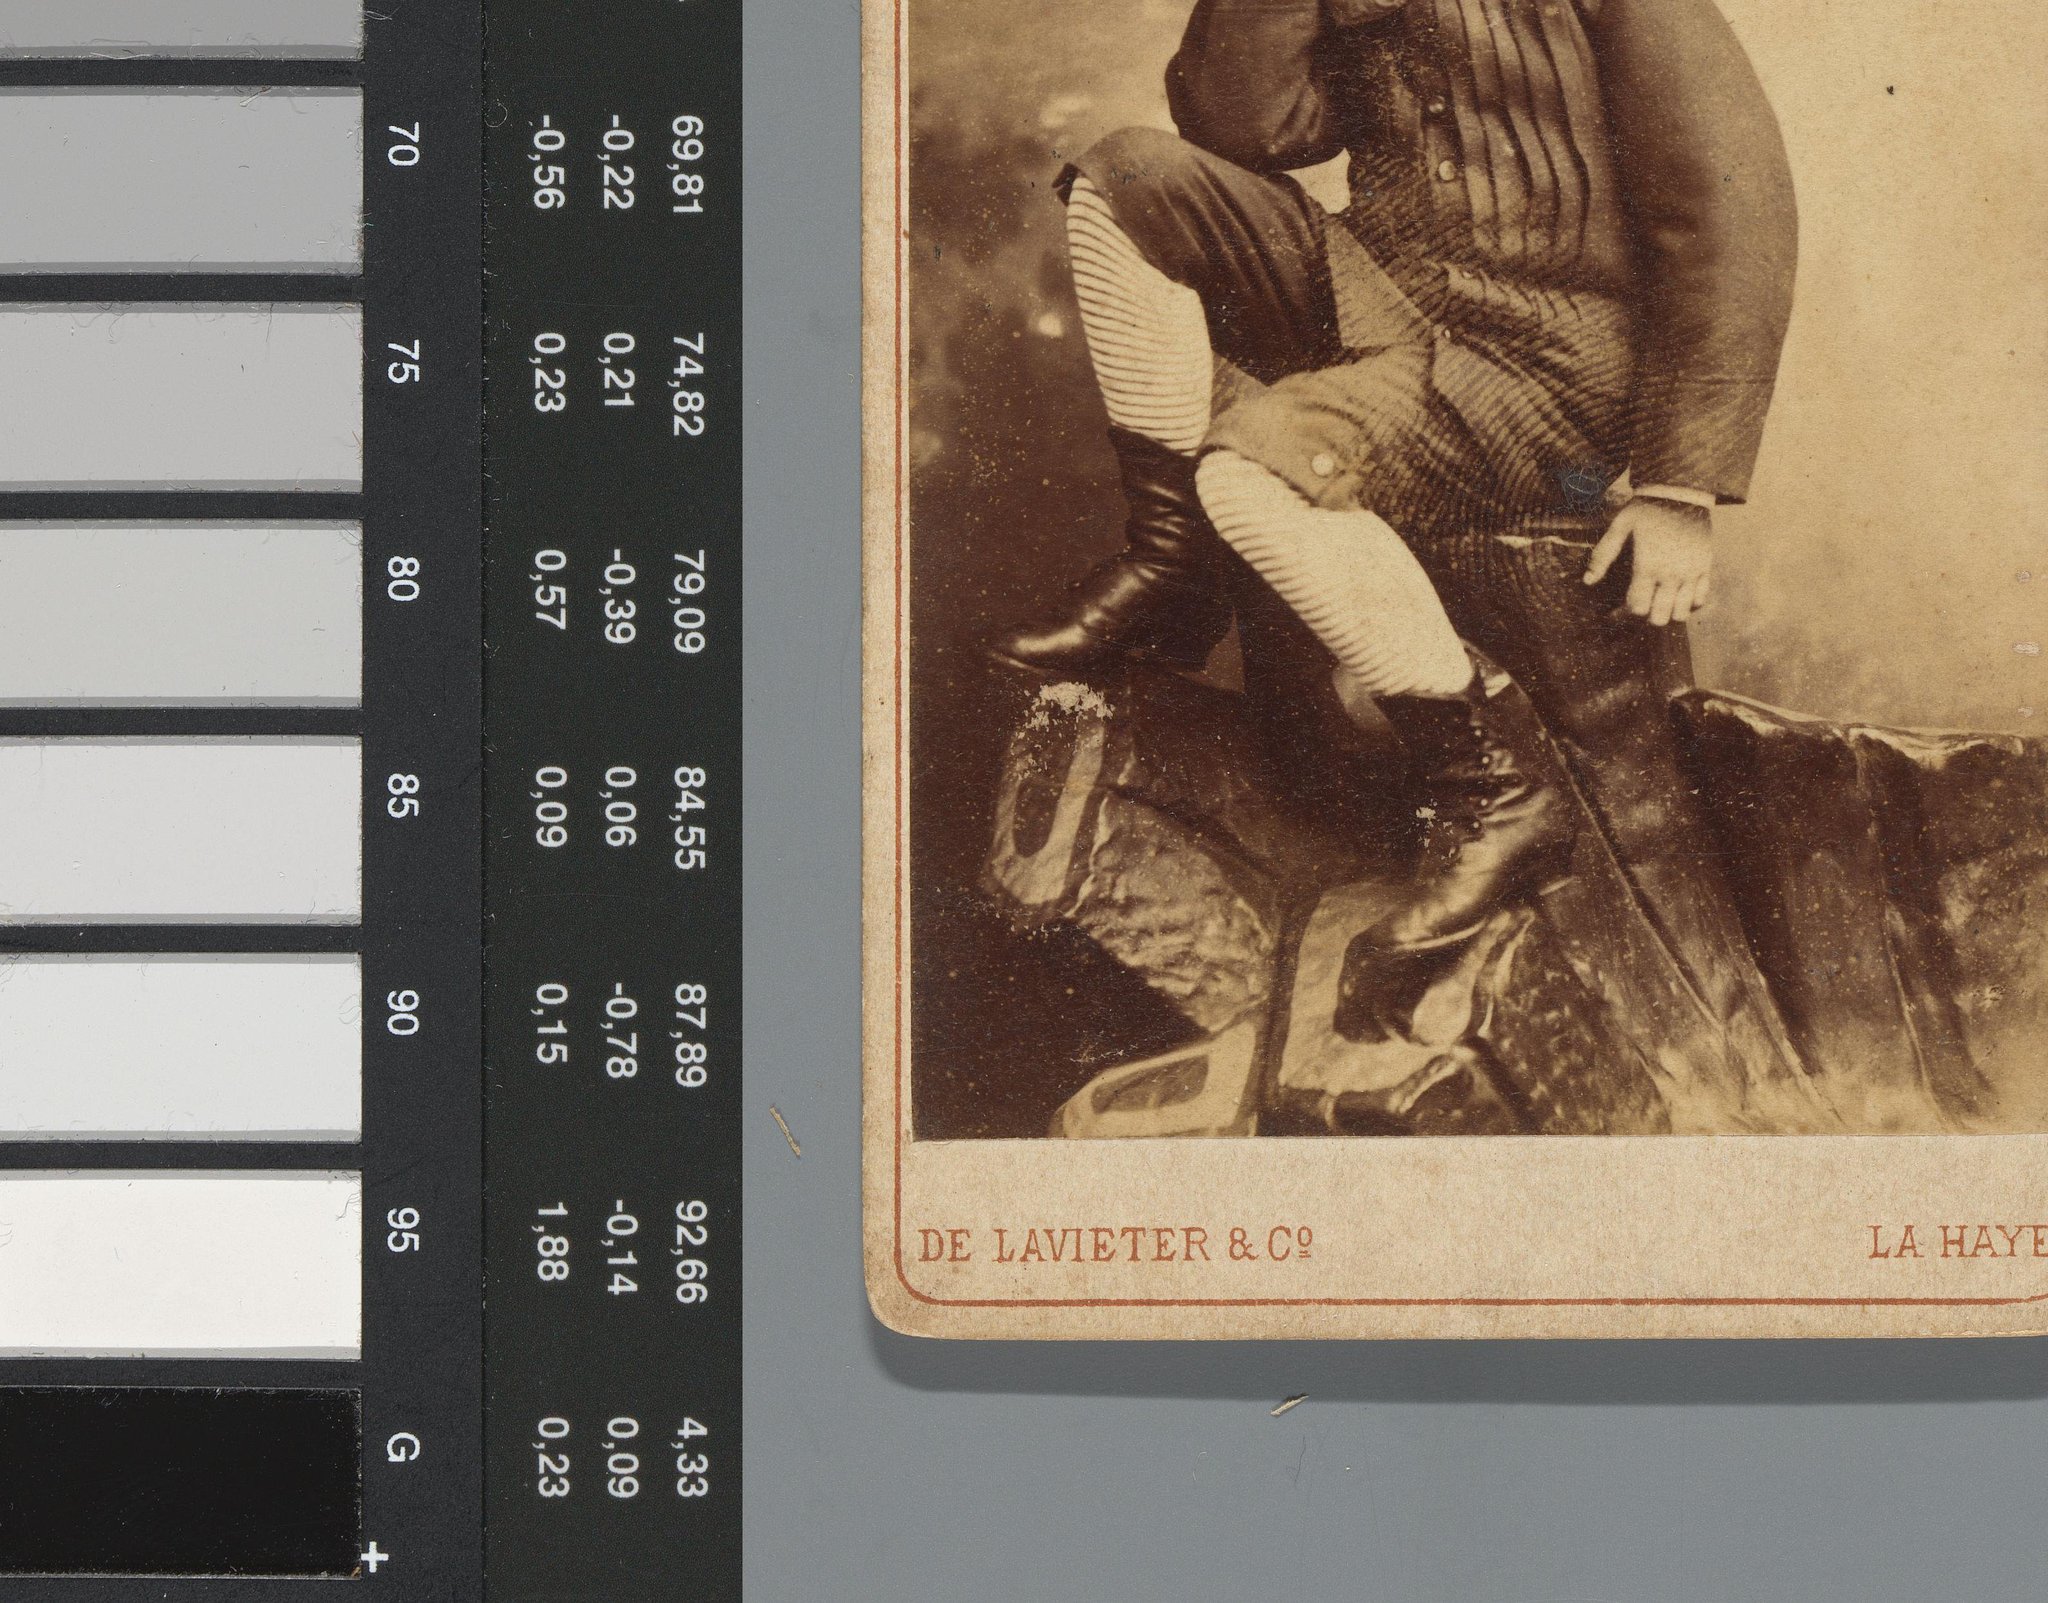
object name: photograph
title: Portret van Hendrik Herman van den Berg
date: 1885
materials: cardboard, photographic support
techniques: albumen print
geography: the hague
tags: hendrik herman van den berg, the hague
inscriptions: name: ‘DE LAVIETER & Co / PHOTOGRAPHES DE S. M. LE ROI, / DE S. A. R. LE PRINCE D' ORANGE / ET DE S. A. R. MADAME LA PRINCESSE HENRI / DES PAYS-BAS. / 2. Willemstraat.-LA HAYE.’, name: ‘DE LAVIETER & Co LA HAYE.’, inscription: ‘vader zj.’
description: Studioportret van Hendrik Herman van den Berg zittend op een boomstronk.